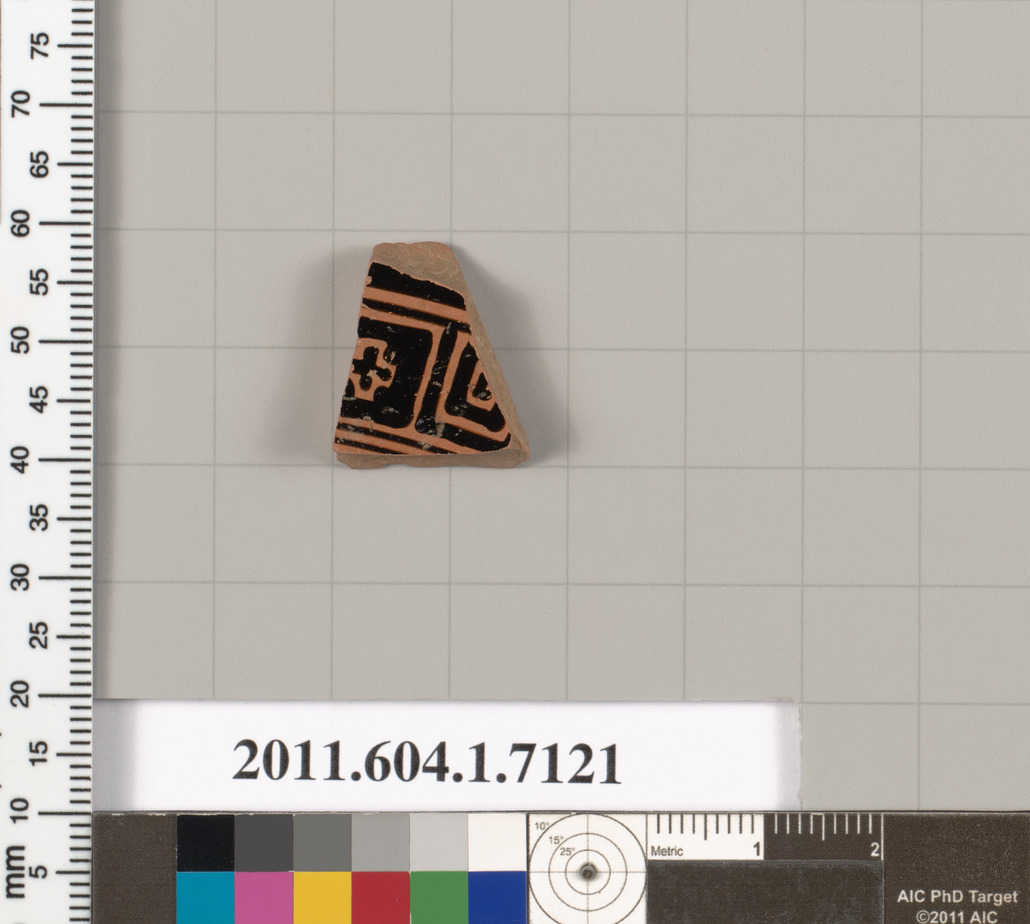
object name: kylix fragment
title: Terracotta fragment of a kylix (drinking cup)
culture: greek, attic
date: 500-480 BCE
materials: terracotta